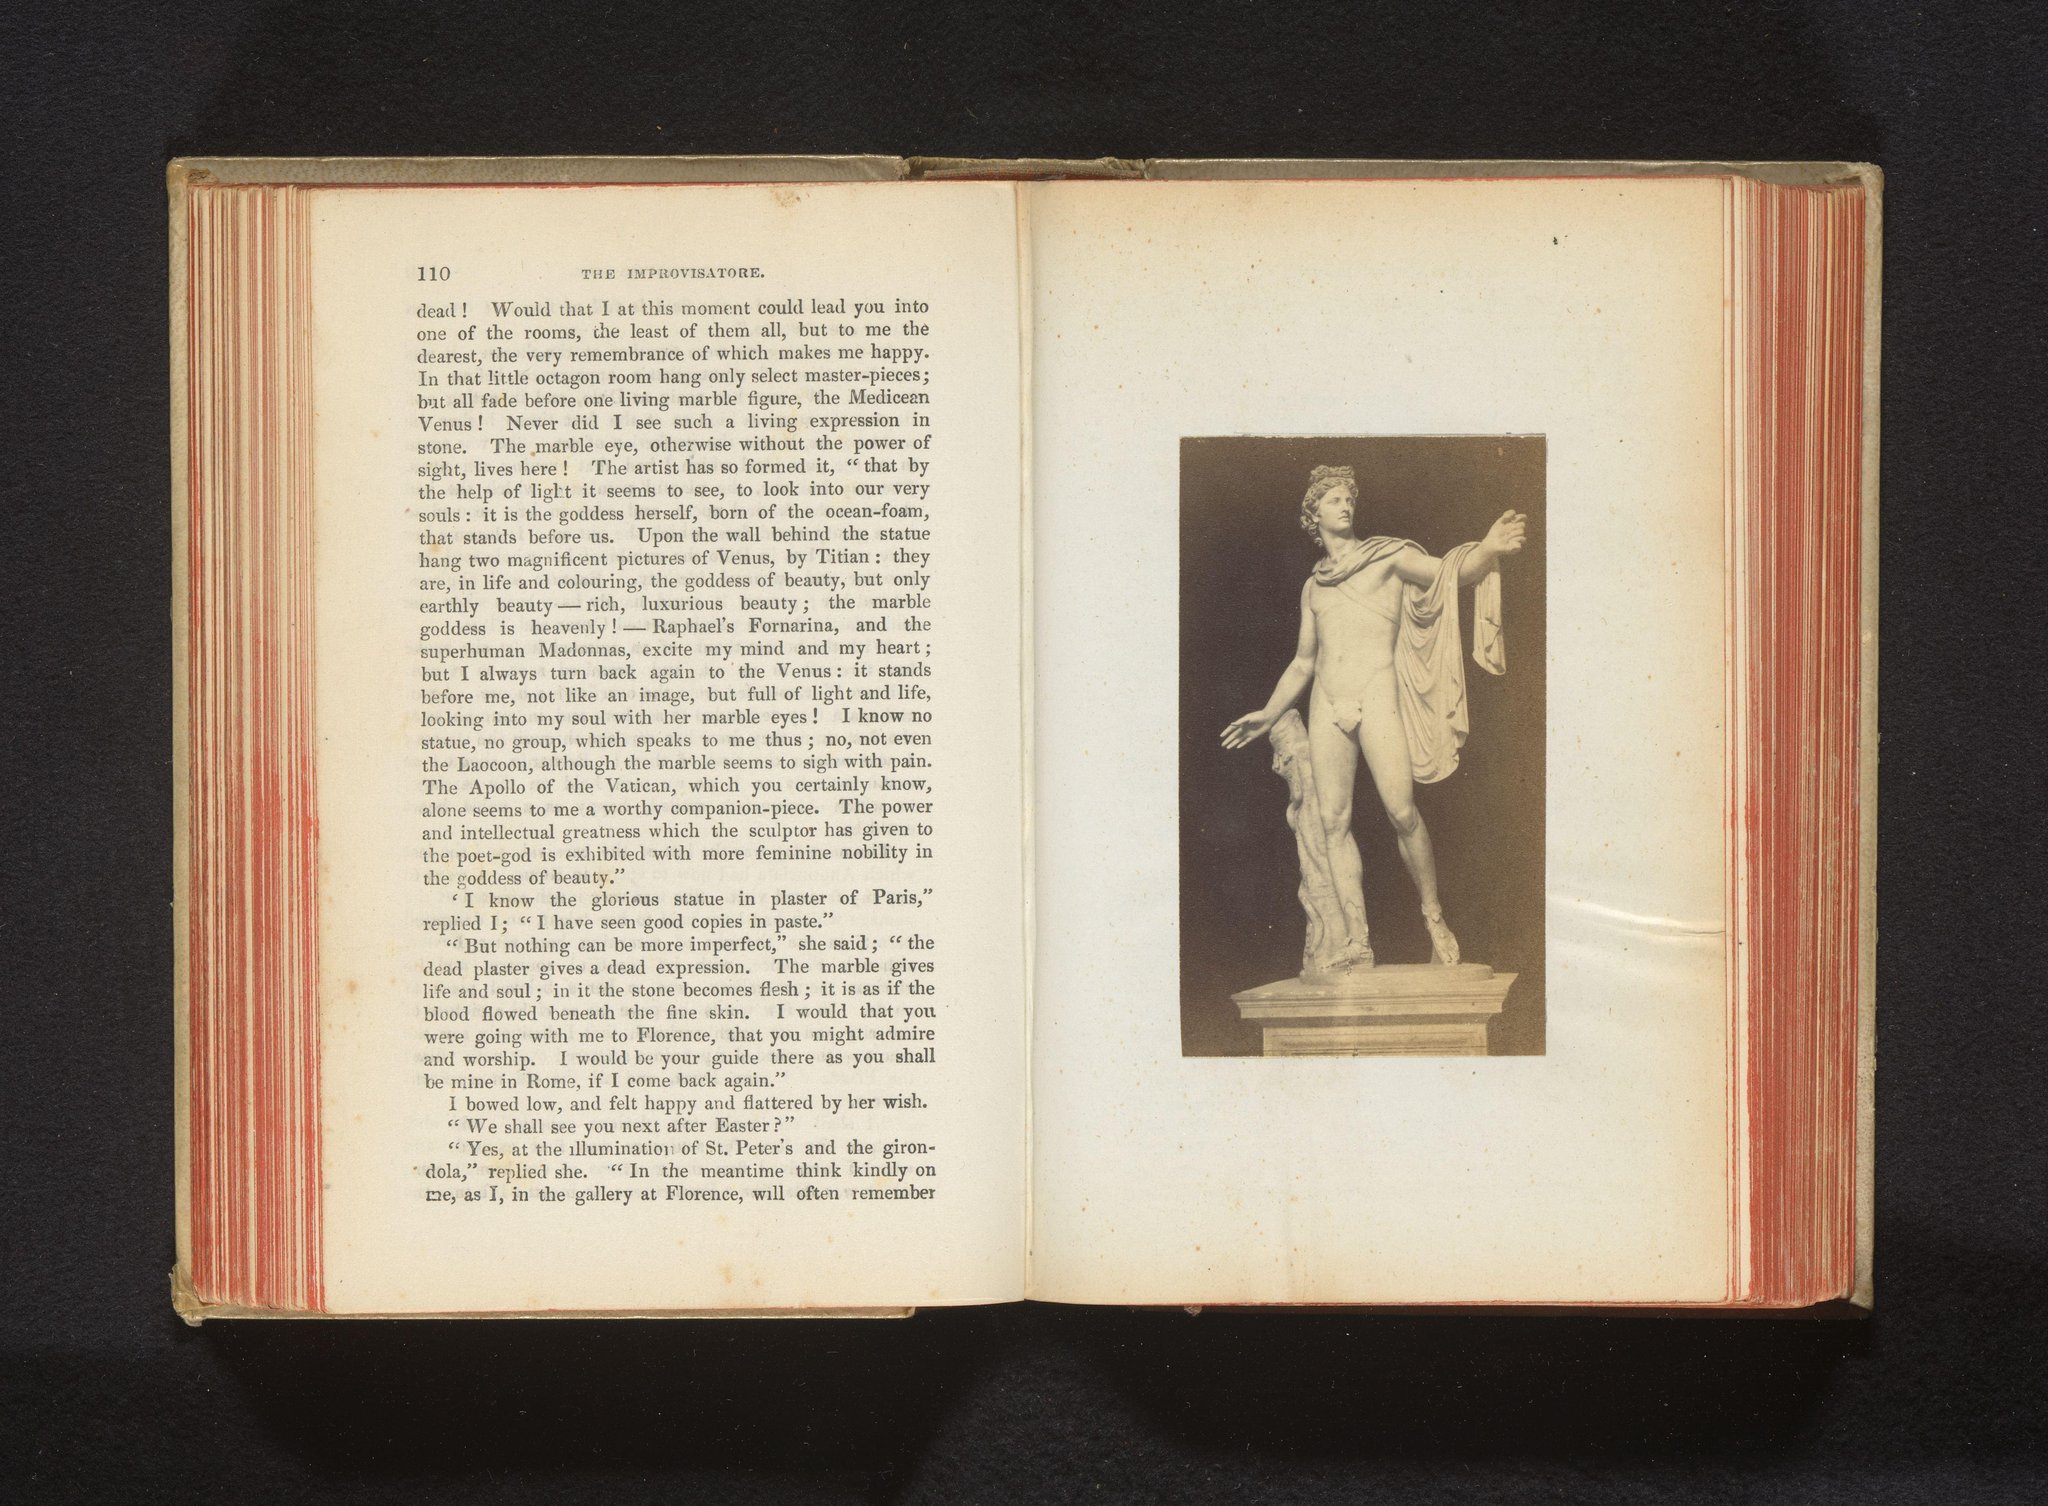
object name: page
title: Apollo van Belvedère in de Vaticaanse Musea te Vaticaanstad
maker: Anonymous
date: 1863-1873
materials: photographic support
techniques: albumen print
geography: rome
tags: (story of) apollo (phoebus), sculpture